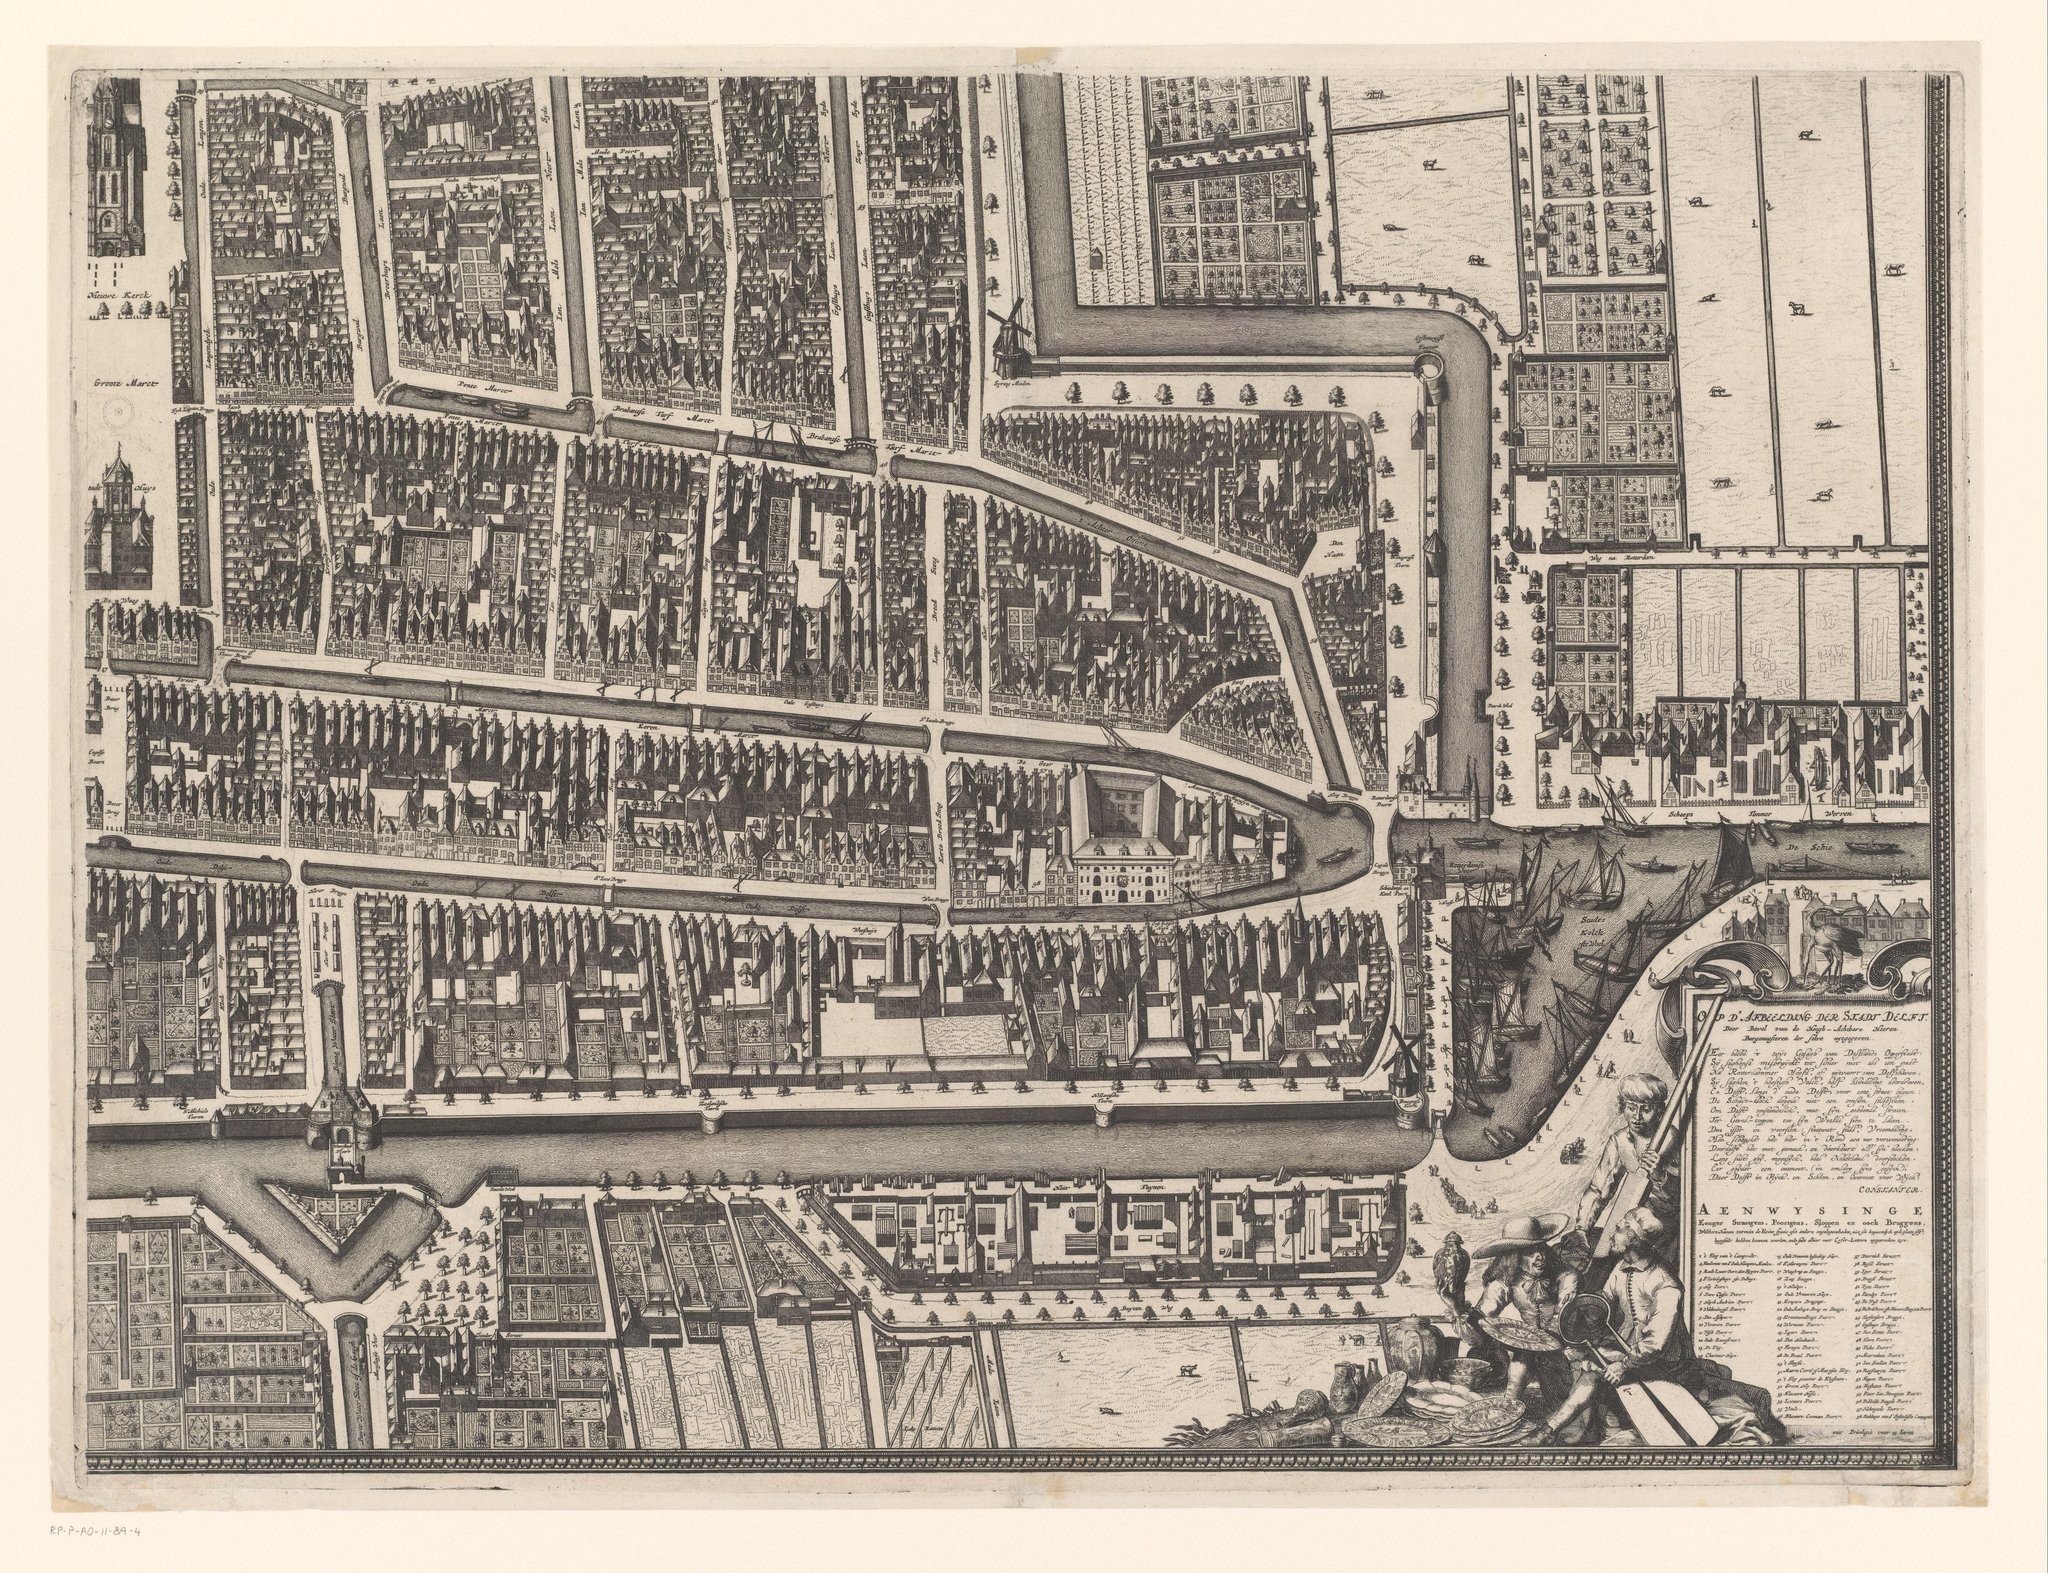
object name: area plan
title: Plattegrond van Delft (deel rechtsonder)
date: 1678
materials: paper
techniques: engraving, etching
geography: delft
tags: maps of cities, delft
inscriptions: collector's mark: Lugt 2228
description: Deze prent is onderdeel van de tweede staat van de plattegrond van de zogenaamde Kaart Figuratief (Caerte figuratyff / Kaerte figuratyf) van Delft, een wandkaart van Delft die voor het eerst werd uitgegeven in 1678. Deze kaart bestaat uit een plattegrond van Delft (RP-P-AO-11-8A) met daaromheen een rand. De rand bestaat uit een profiel van Delft (RP-P-AO-11-11), een profiel van Delfshaven met daaronder de wapenschilden van de burgemeesters van de stad (RP-P-AO-13-51-1 en RP-P-AO-13-51-2), 24 kleinere prenten (kaarten, afbeeldingen van gebouwen en graven van bekende personen, o.a. RP-P-AO-11-15, RP-P-AO-11-16, RP-P-AO-11-17, RP-P-AO-11-18, RP-P-AO-11-19, RP-P-AO-11-20, RP-P-AO-11-21, RP-P-AO-11-23, RP-P-AO-11-24, RP-P-AO-11-27, RP-P-AO-11-28, RP-P-AO-11-29, RP-P-AO-11-30, RP-P-AO-11-31, RP-P-AO-11-33C, RP-P-AO-11-34, RP-P-AO-11-35, RP-P-AO-11-35-2, RP-P-AO-13-49, RP-P-AO-13-52, RP-P-AO-13-53, RP-P-AO-13-54-1 en RP-P-1909-6463) en een beschrijving van de stad (RP-P-AO-11-8E). In 1678 werd de kaart, in opdracht van het Delftse stadsbestuur, voor het eerst in zijn geheel uitgegeven door Pieter Smith. Pieter Mortier (I) verzorgde in 1703, tevens in opdracht van het stadsbestuur, een tweede uitgave. Voor deze druk bracht graveur Thomas van der Wilt enkele aanpassingen aan op de platen van de plattegrond. De randplaten lijken ongewijzigd te zijn gebleven, hoewel de plaat met de wapens van de burgemeesters werd vervangen door een nieuwe plaat met wapens van de toen zittende burgemeesters. Van de plattegrond zijn dus twee staten bekend. De tweede staat van de plattegrond is in 1752, waarschijnlijk zonder de randprenten, opnieuw uitgegeven. Het is onbekend wie deze druk heeft verzorgd. De kaart kon op verschillende manieren gemonteerd worden. Voor zowel de uitgave van 1678 als die van 1703 is een instructie bekend. Voor een exemplaar van de instructie uit 1703 zie RP-P-AO-11-93.